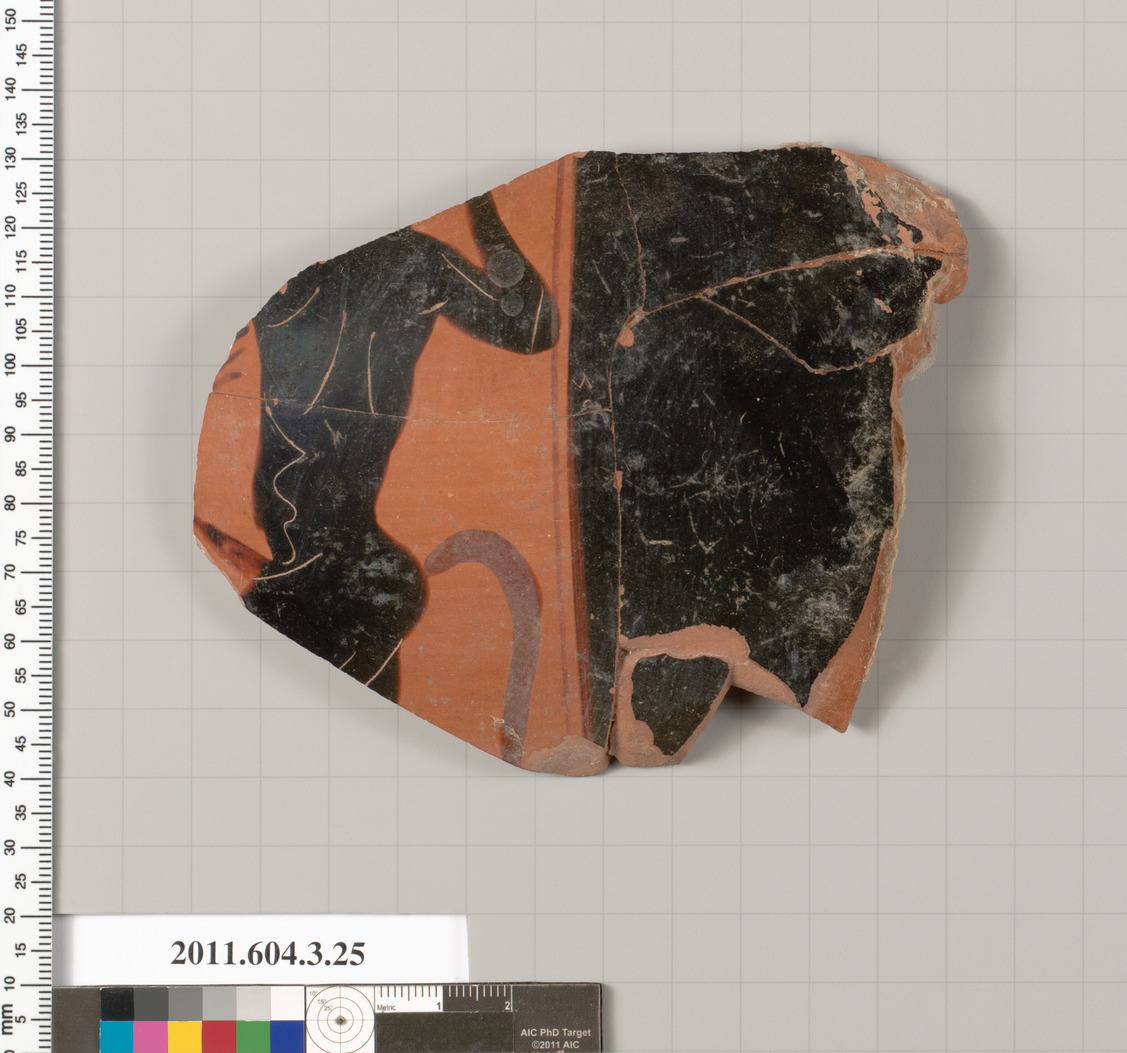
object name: amphora fragment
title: Terracotta fragment of an amphora (jar)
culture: greek, attic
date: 534-468 BCE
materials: terracotta